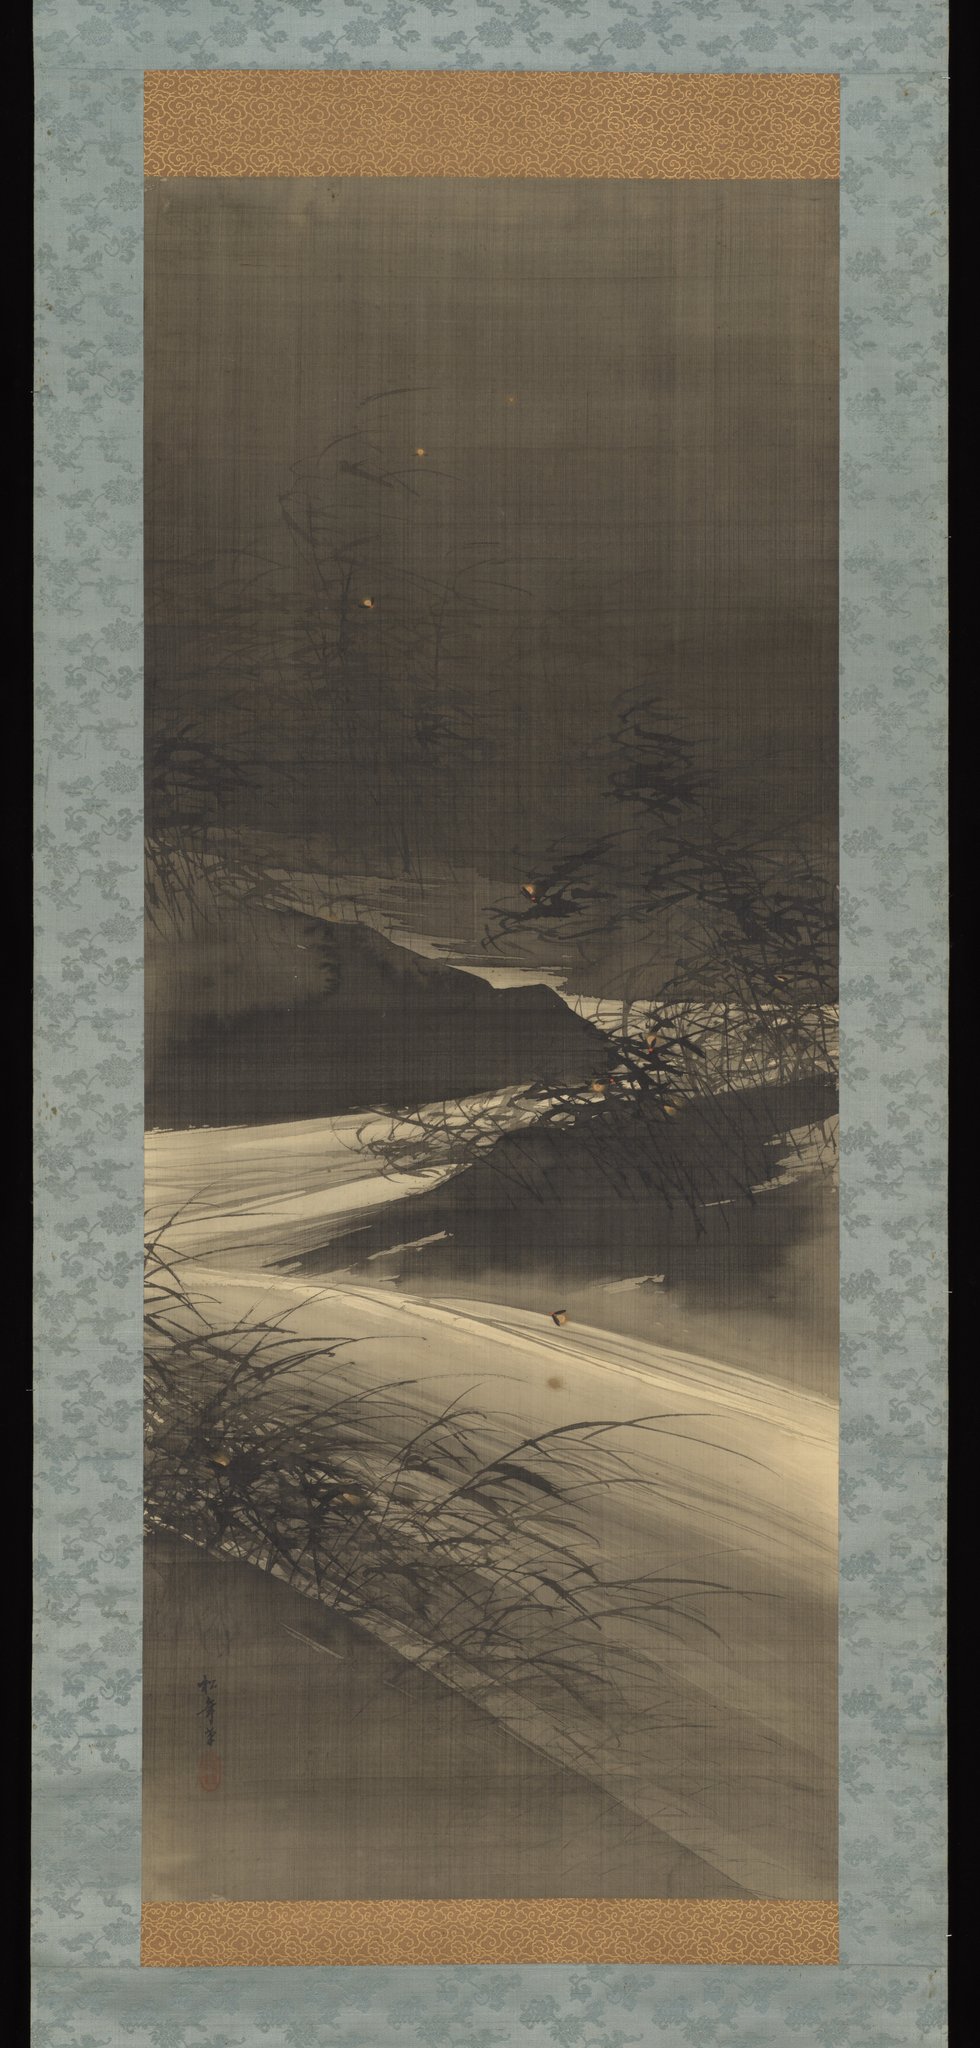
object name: hanging scroll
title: Fireflies Over the Uji River by Moonlight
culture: japanese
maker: suzuki shōnen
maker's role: artist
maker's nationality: japanese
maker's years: 1849-1918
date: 1868-1912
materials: gold, ink, silk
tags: rivers